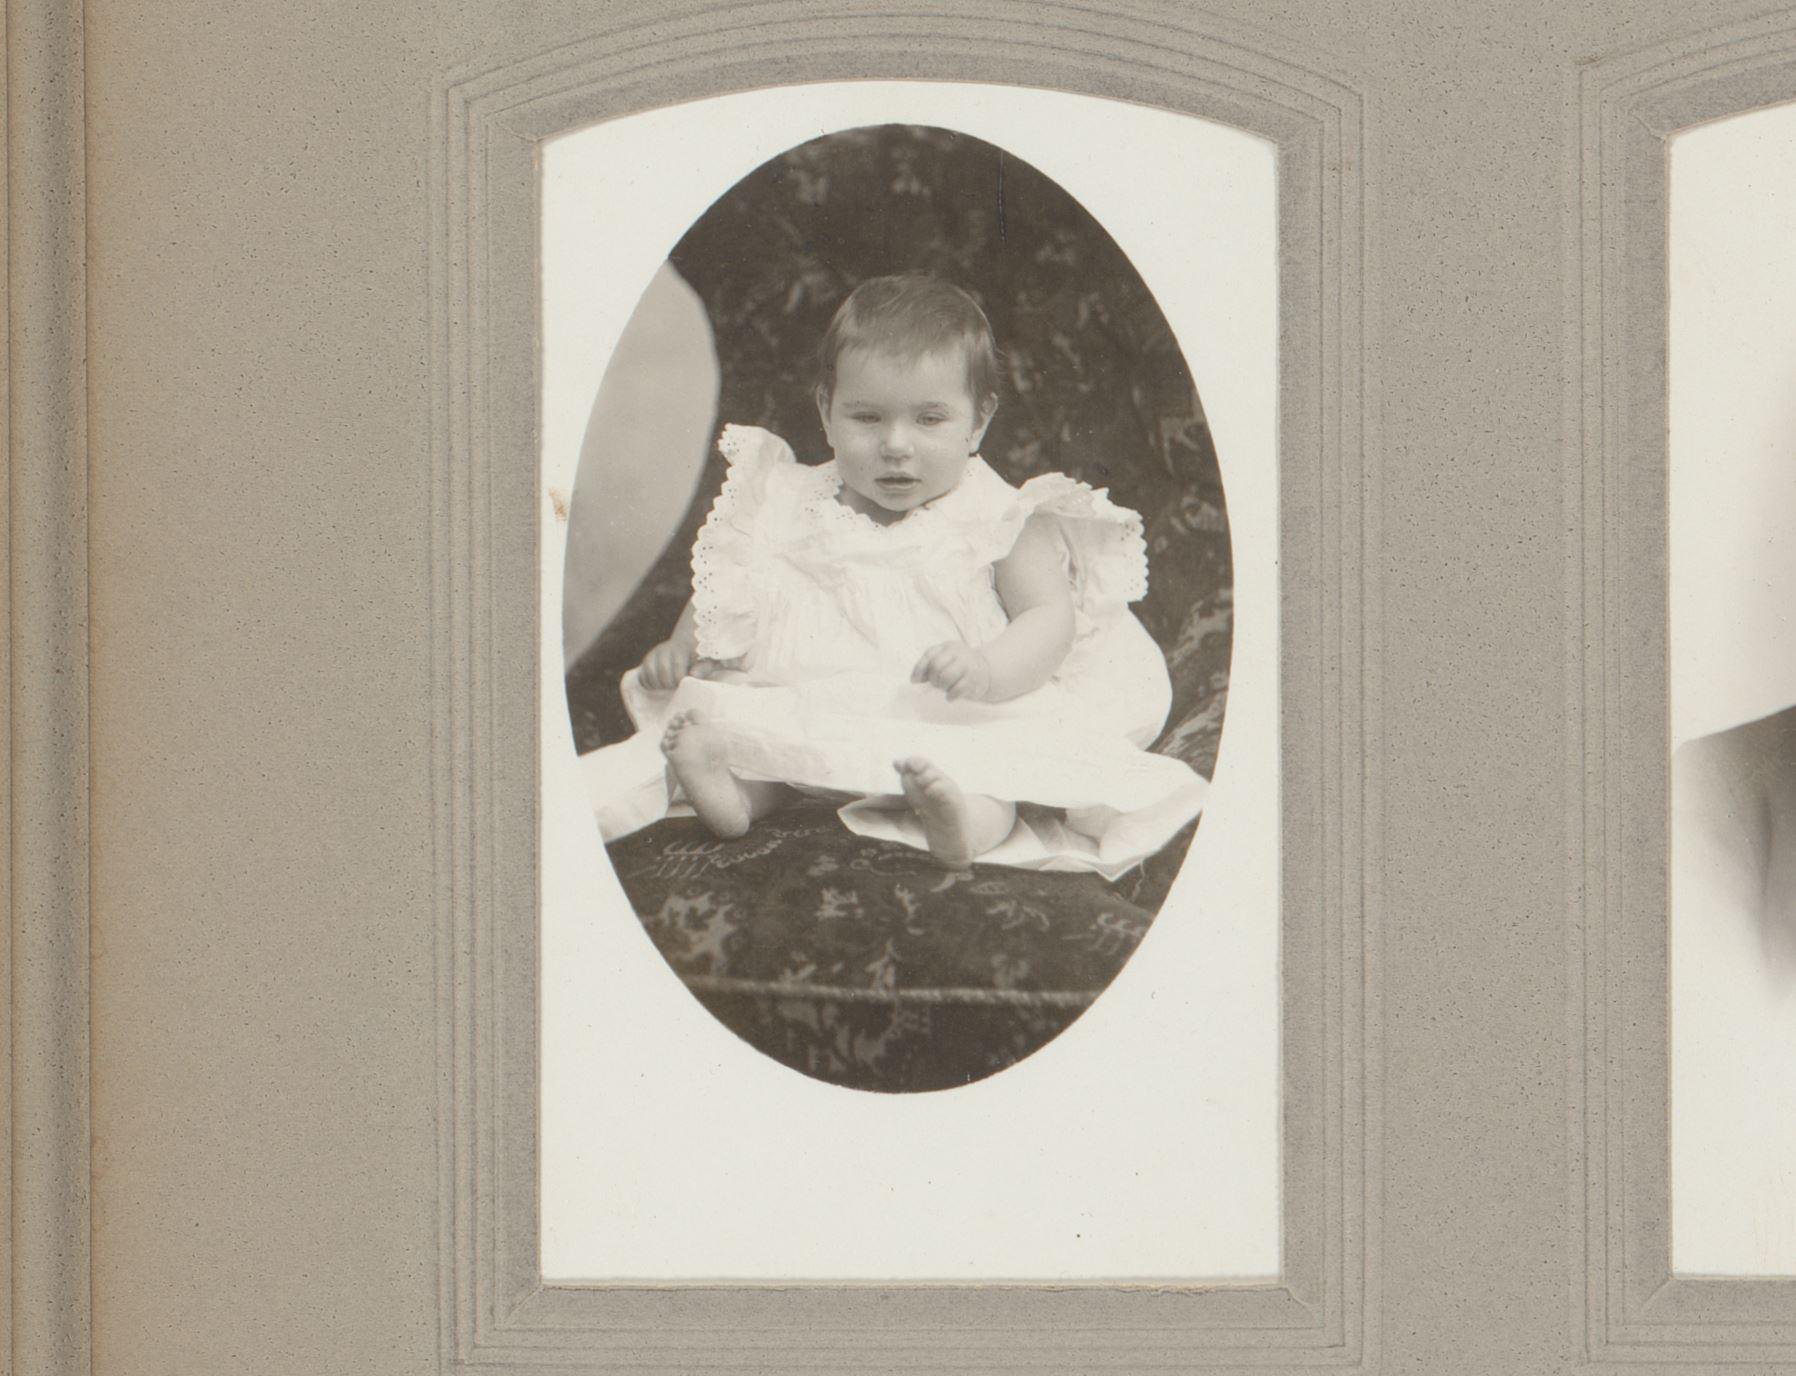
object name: album leaf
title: Portret van een zittende baby in witte jurk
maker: carl sandels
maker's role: fotograaf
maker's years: 1845-1919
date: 1895-1920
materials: cardboard, photographic support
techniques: matte daylight collodion silver print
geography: stockholm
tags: sitting figure, historical persons, infant, baby ~ the ages of man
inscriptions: inscription: ‘Fotograf Sandels/ Stockholm/ Fredsgatan 15.’